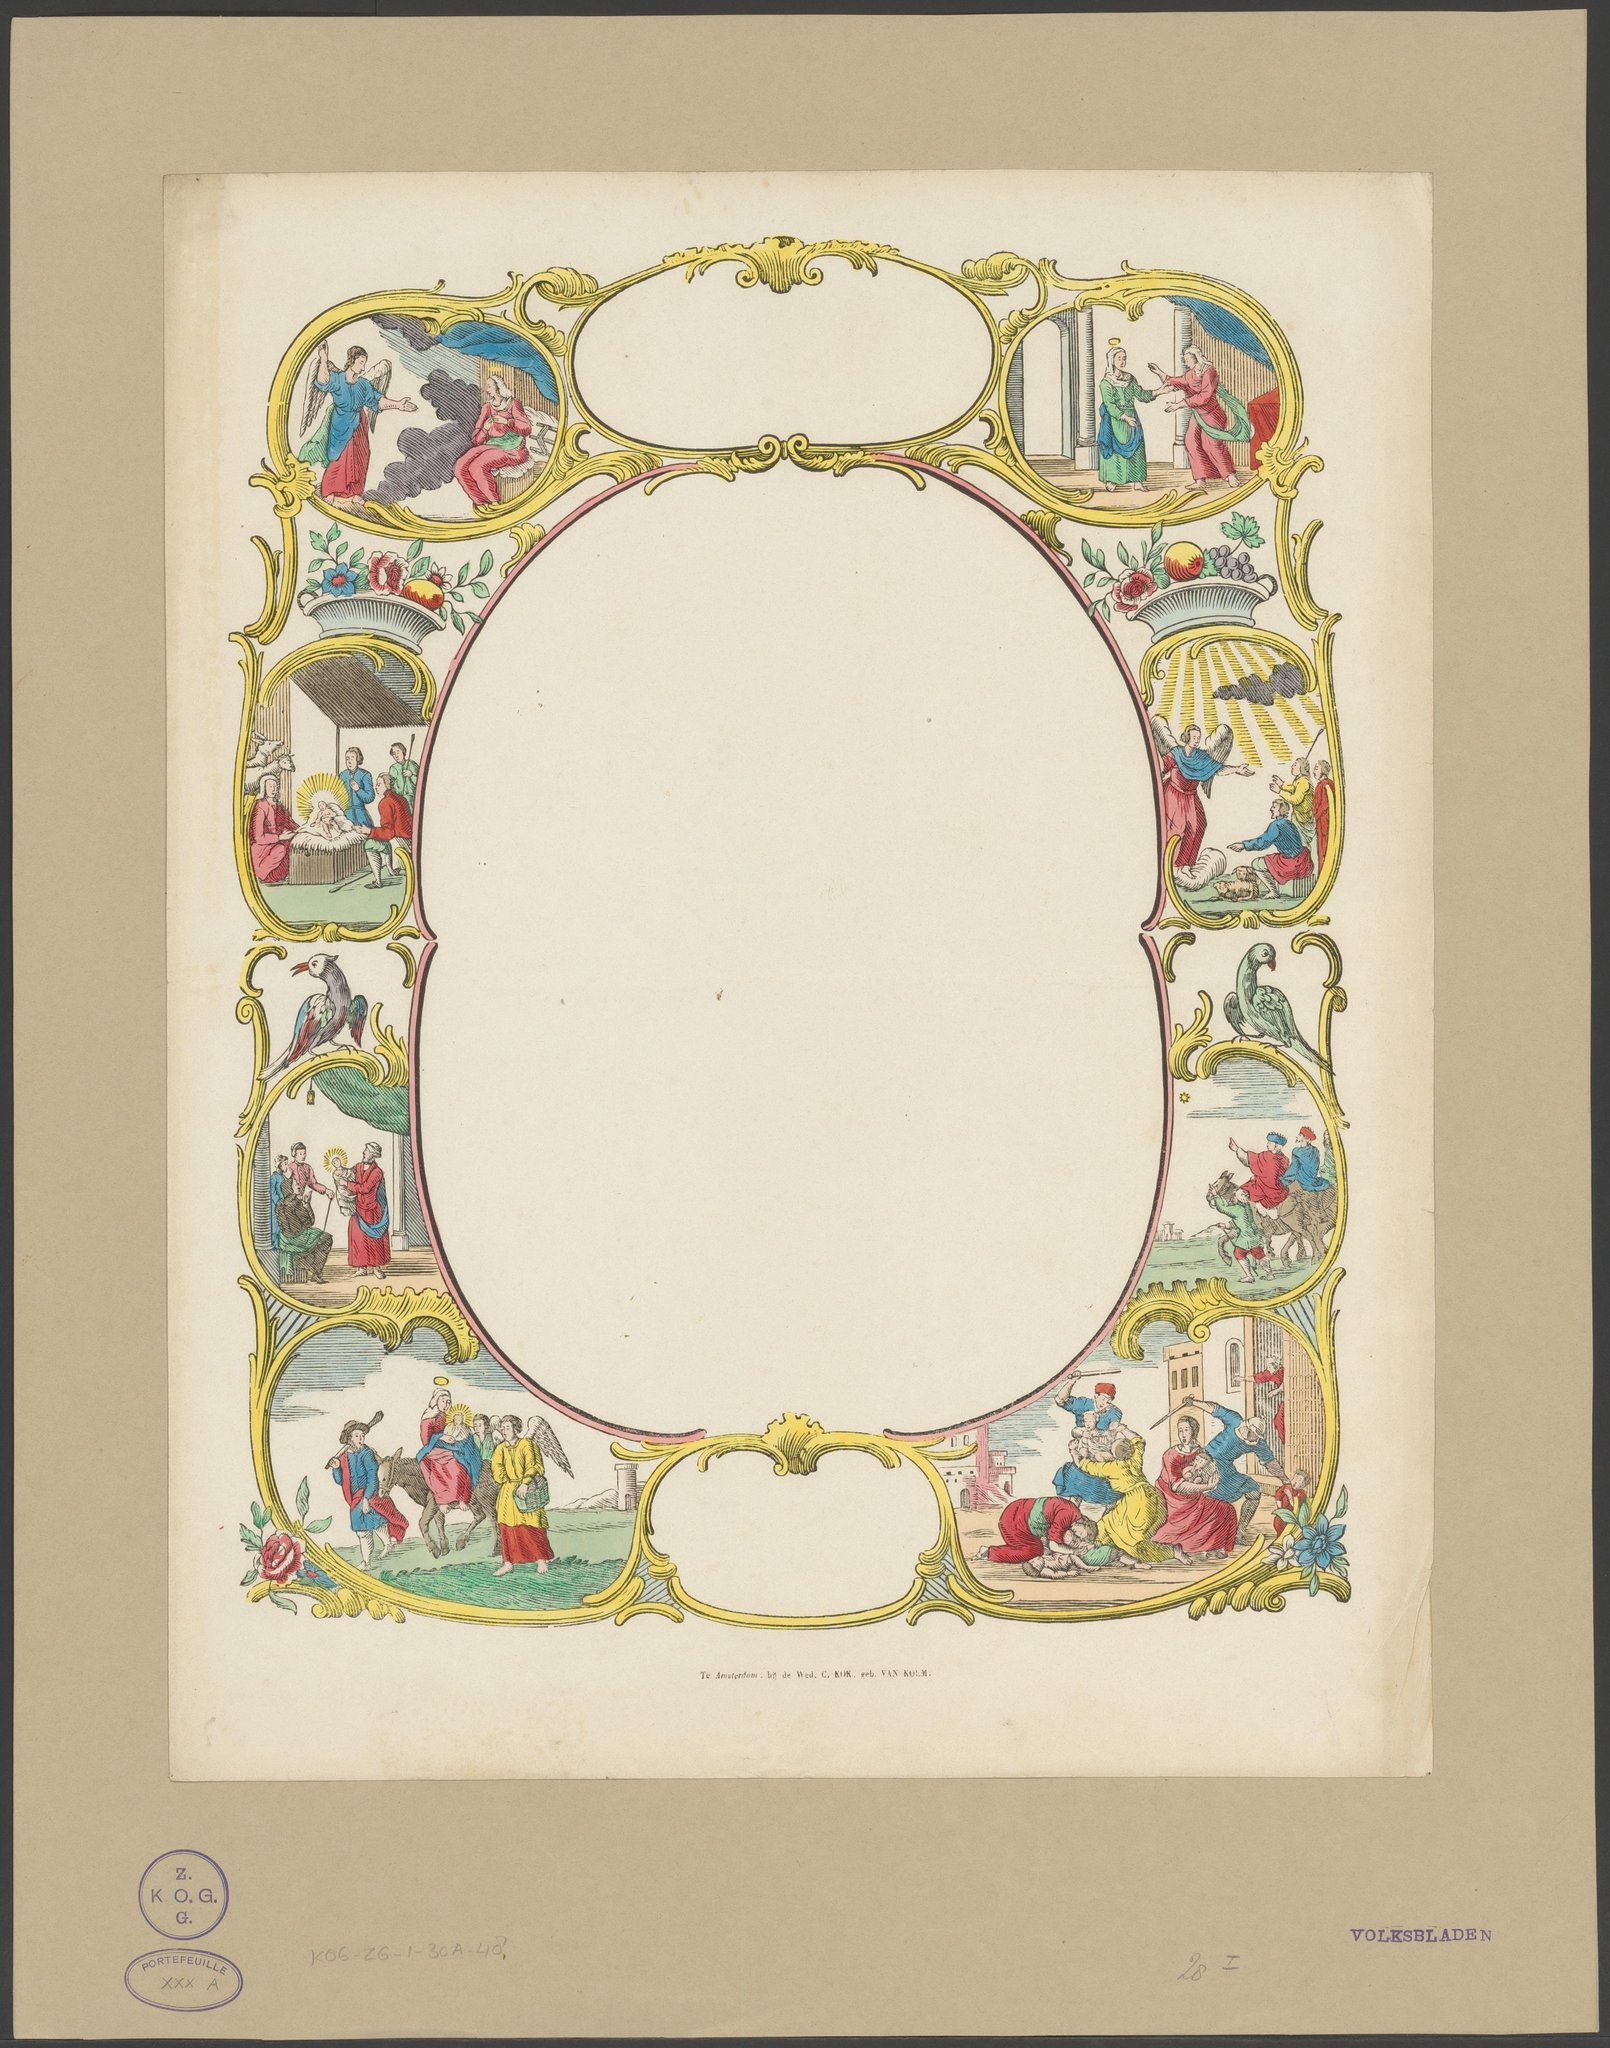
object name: wensbrief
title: Blanco wensbrief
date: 1842-1866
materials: paper, watercolor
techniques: hand coloring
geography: netherlands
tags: birth and youth of christ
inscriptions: collector's mark, collector's mark: Lugt 1641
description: Blanco wensbrief. Onbeschreven cartouche op een voorgedrukt blad met een kader gevormd door scènes uit het verhaal van de geboorte van Christus. Onderwerpsrubrieken binnen de Atlas Zeden en Gewoonten: Nieuwjaars- en kermiswenschen.